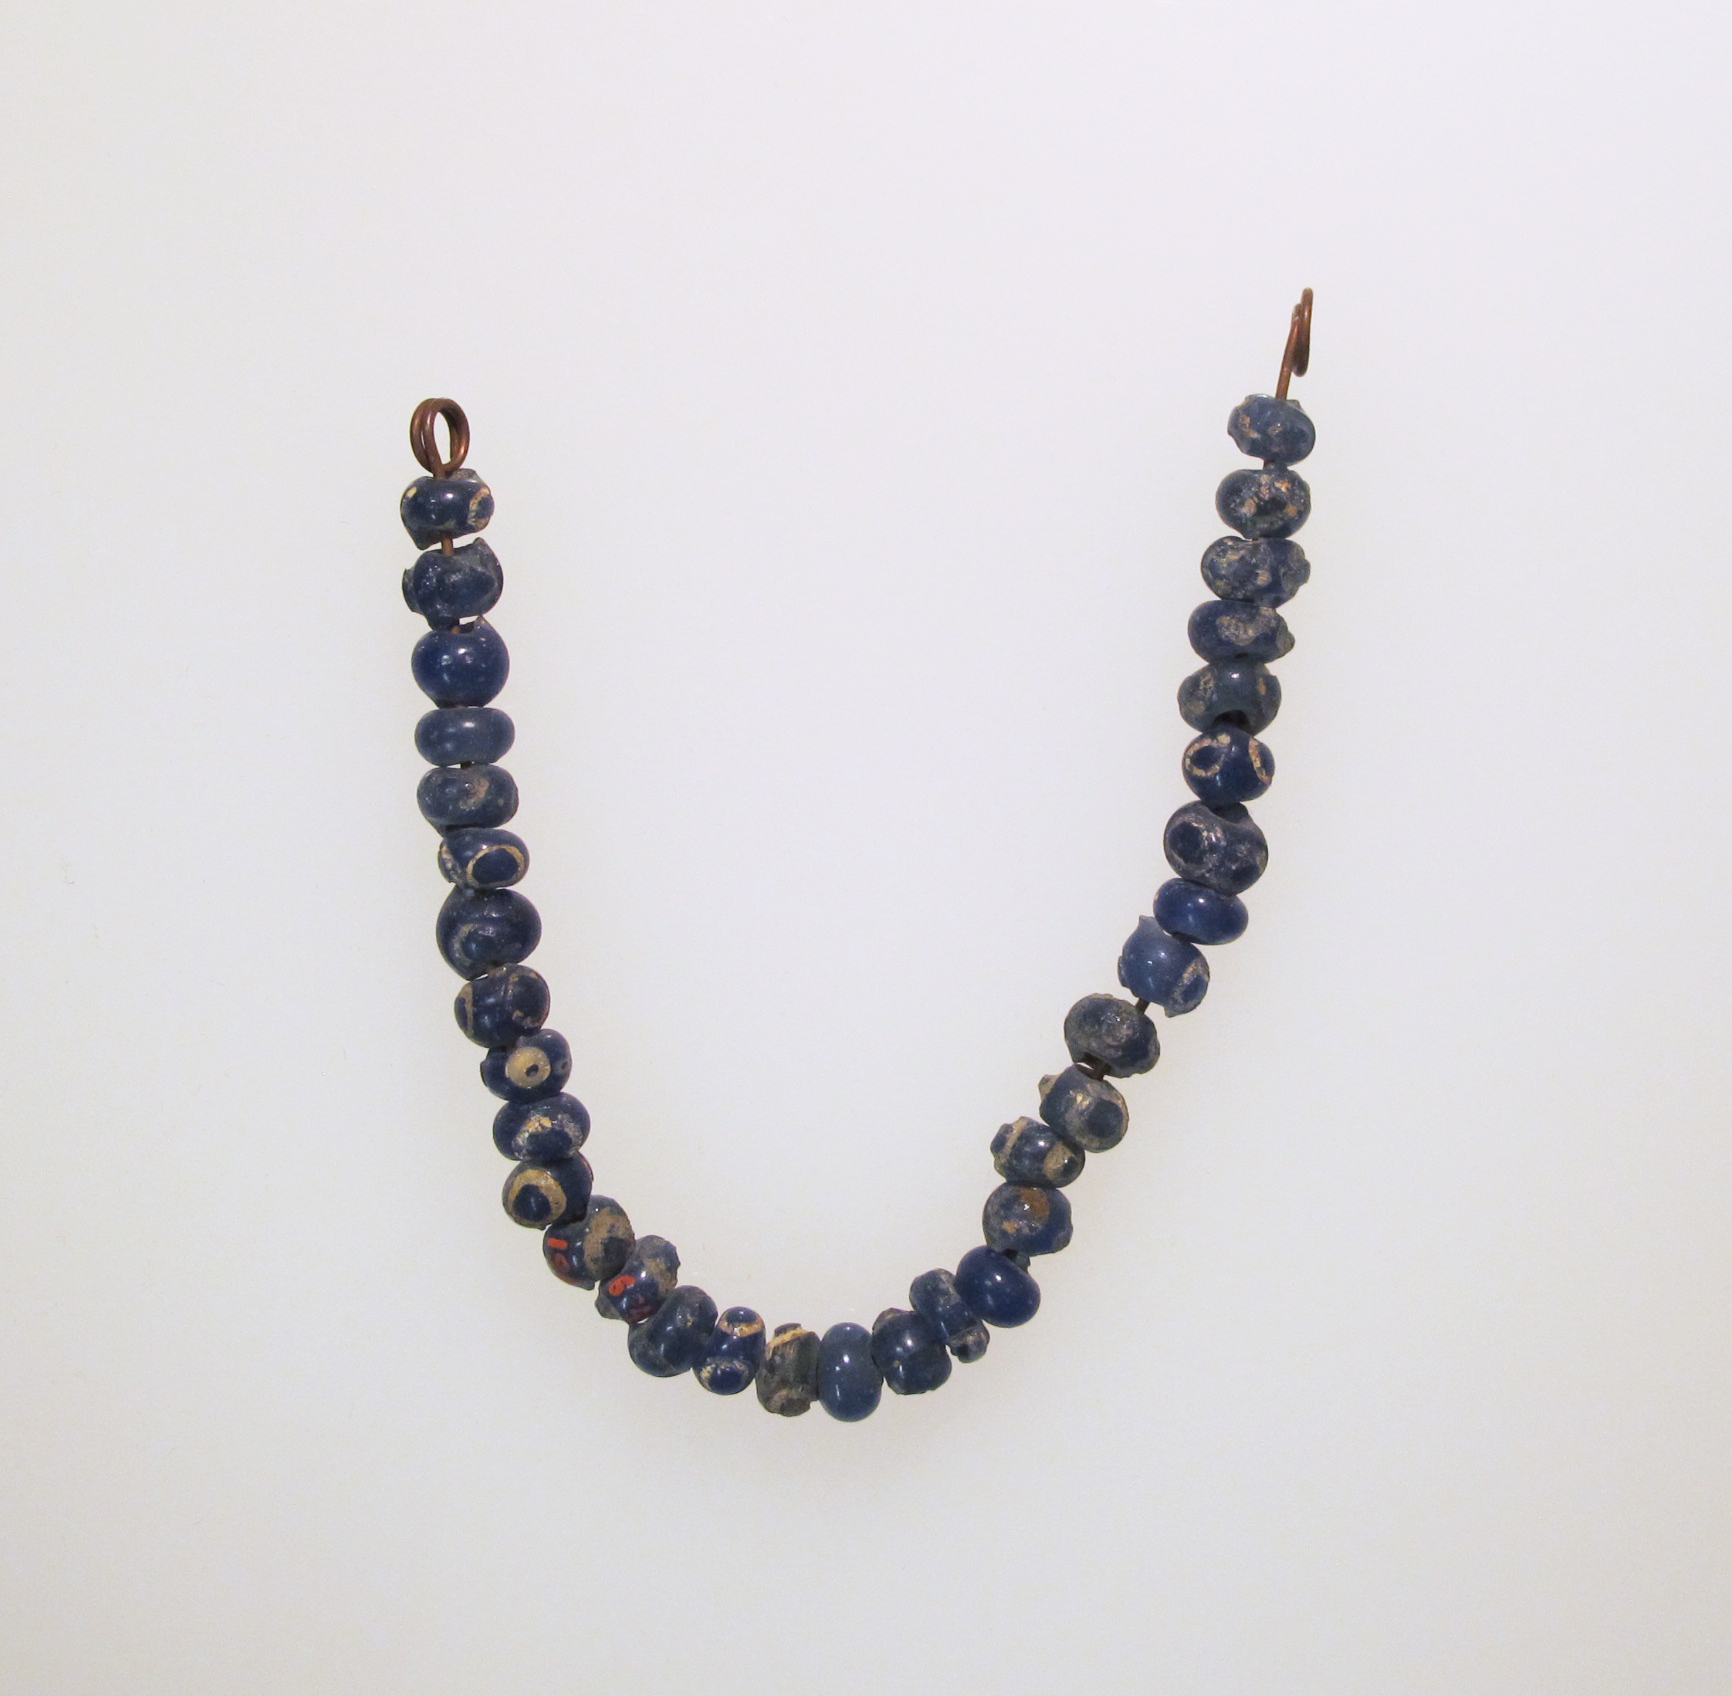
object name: bead 33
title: Glass eye beads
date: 7000 BCE-330 CE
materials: glass